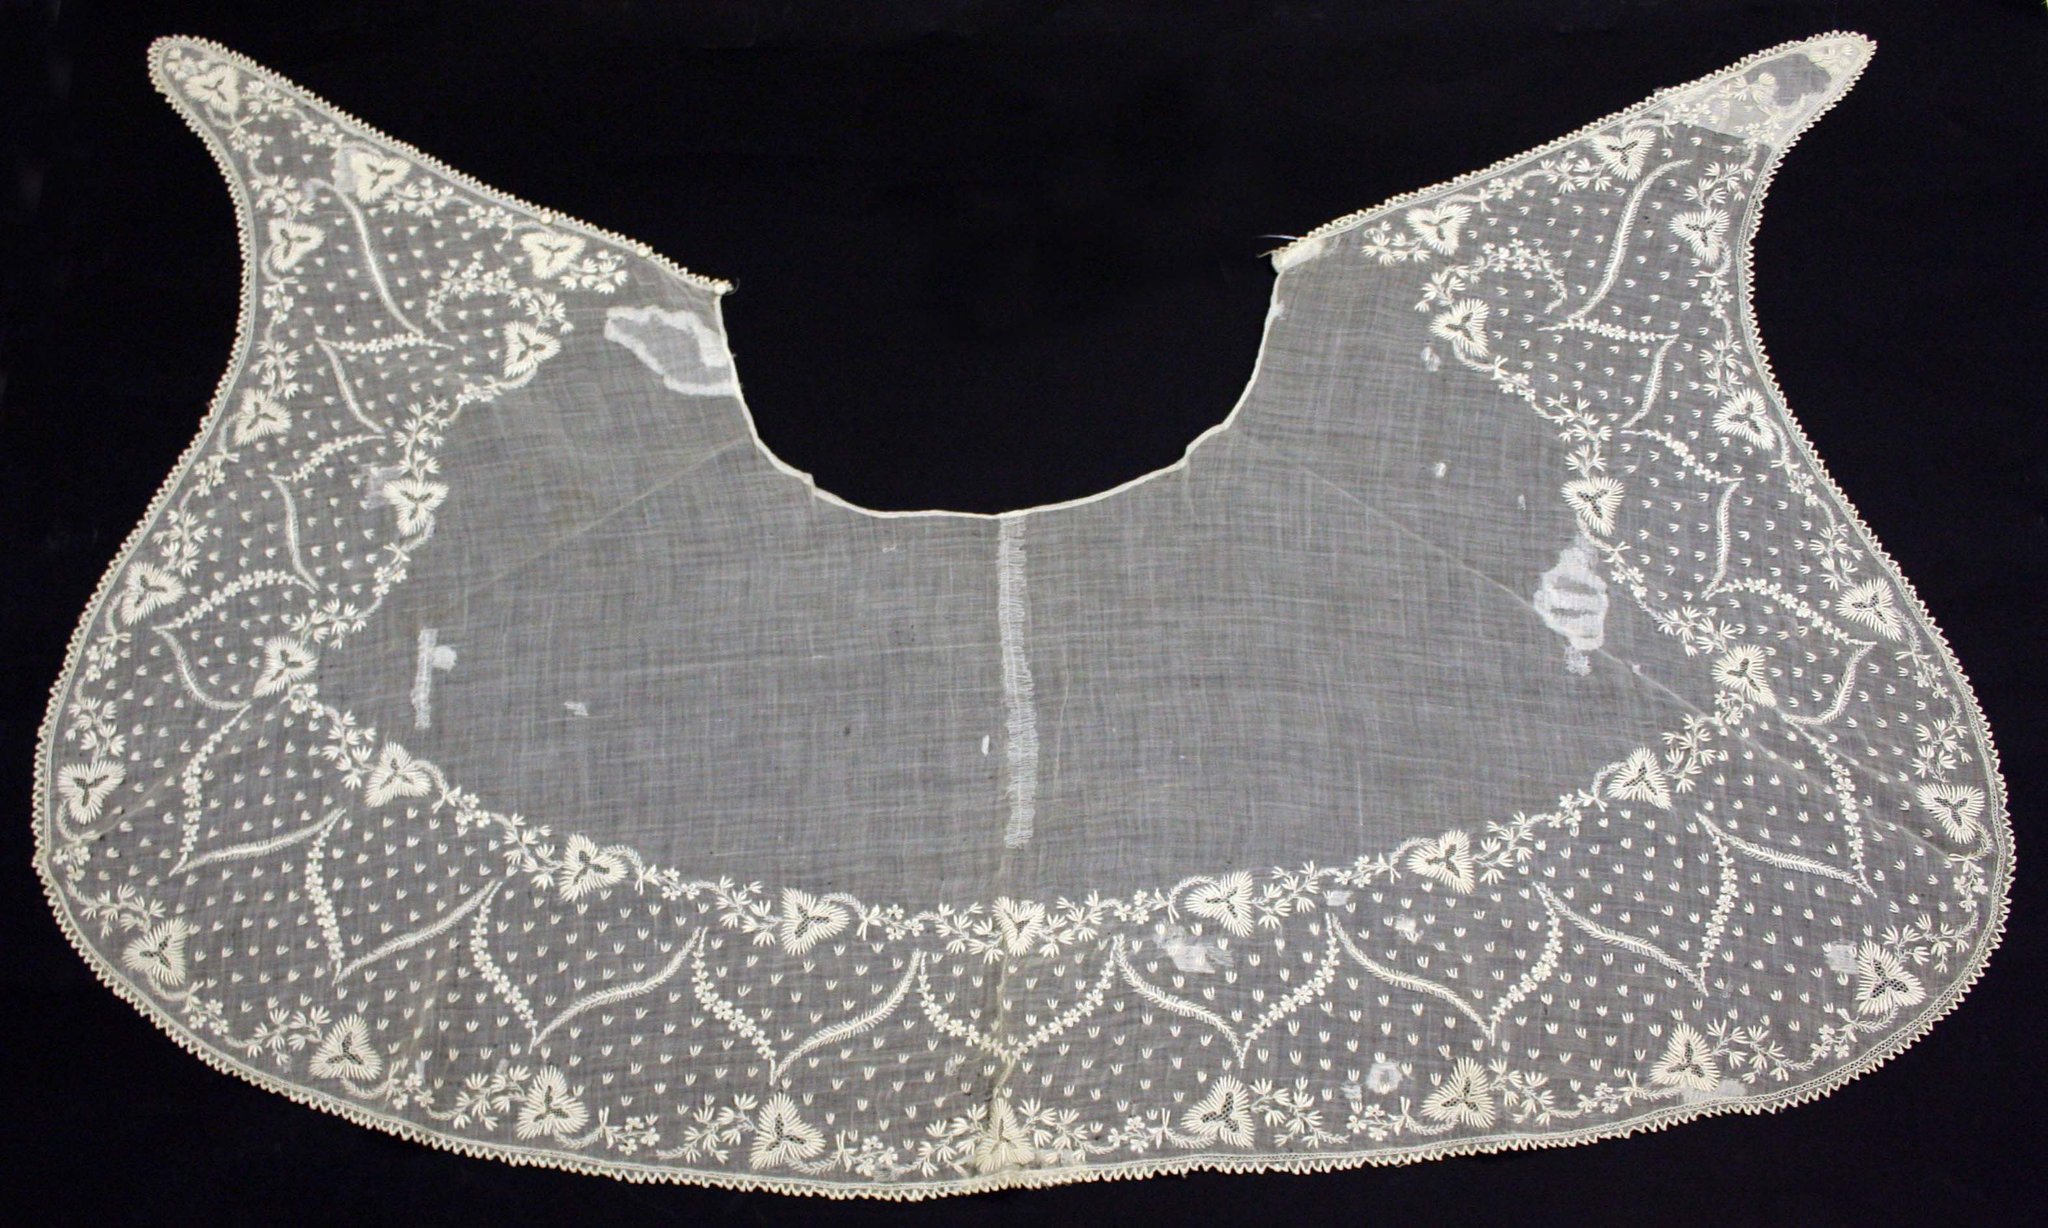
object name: neckerchief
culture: american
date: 1700-1938